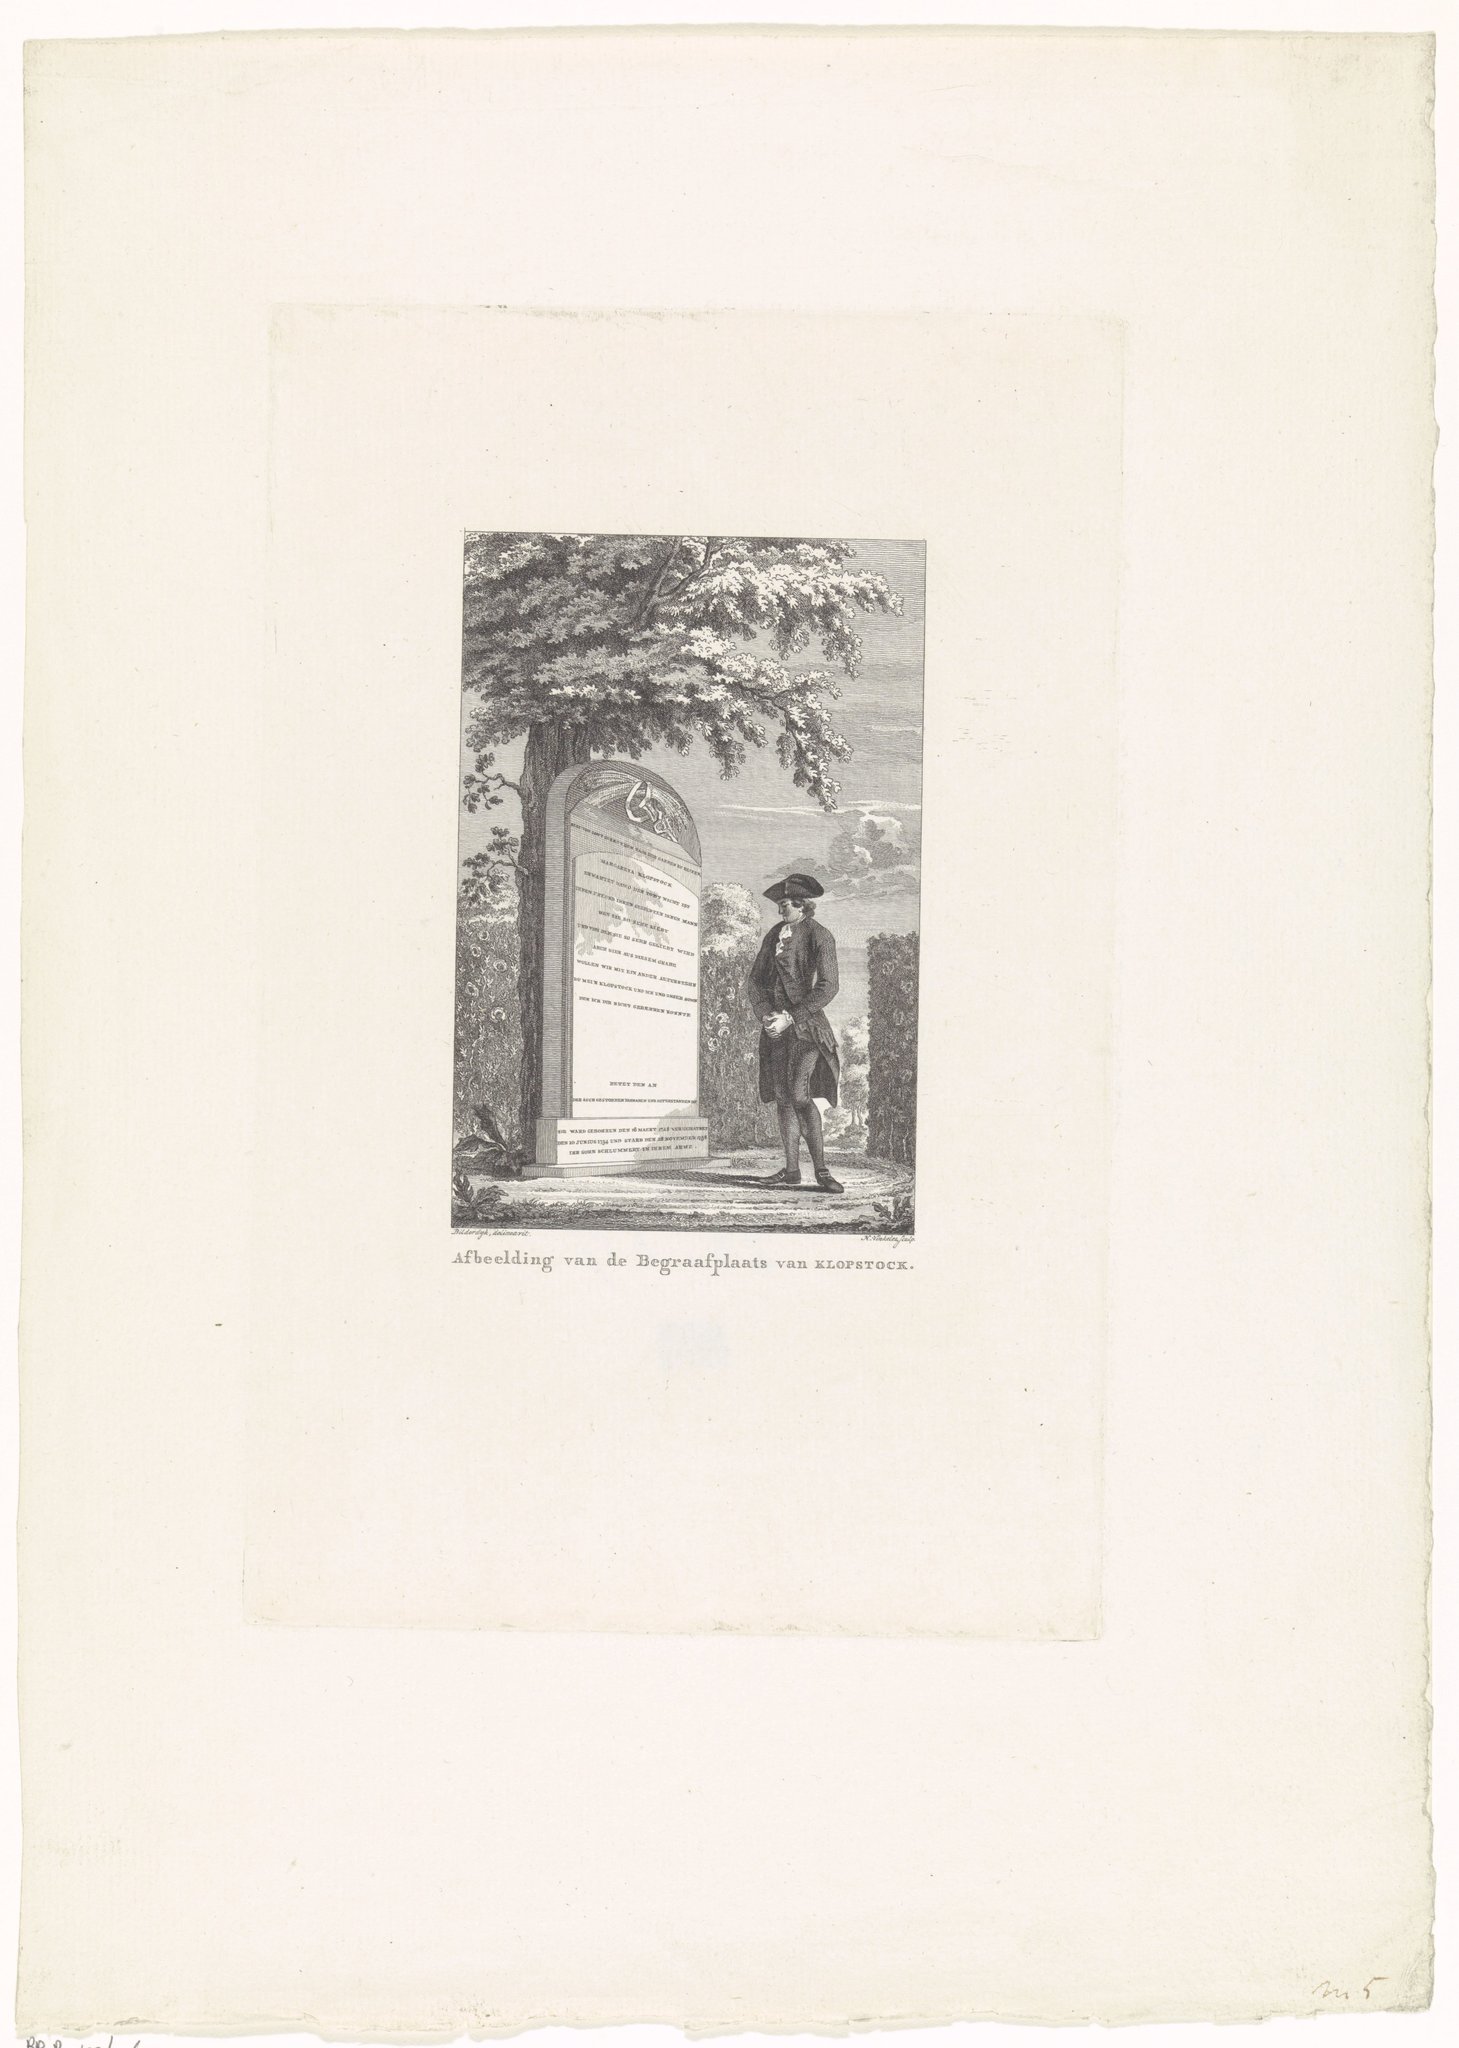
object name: print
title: Graf van Margareta Klopstock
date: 1758-1800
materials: paper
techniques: etching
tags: grave, tomb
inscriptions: collector's mark: Lugt 2166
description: Een man staat bij de grafzerk van de Duitse schrijftser Margareta Klopstock te Ottensen.